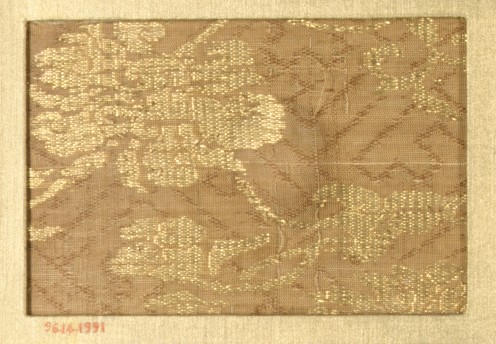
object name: piece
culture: japanese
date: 1701-1900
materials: silk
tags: flowers